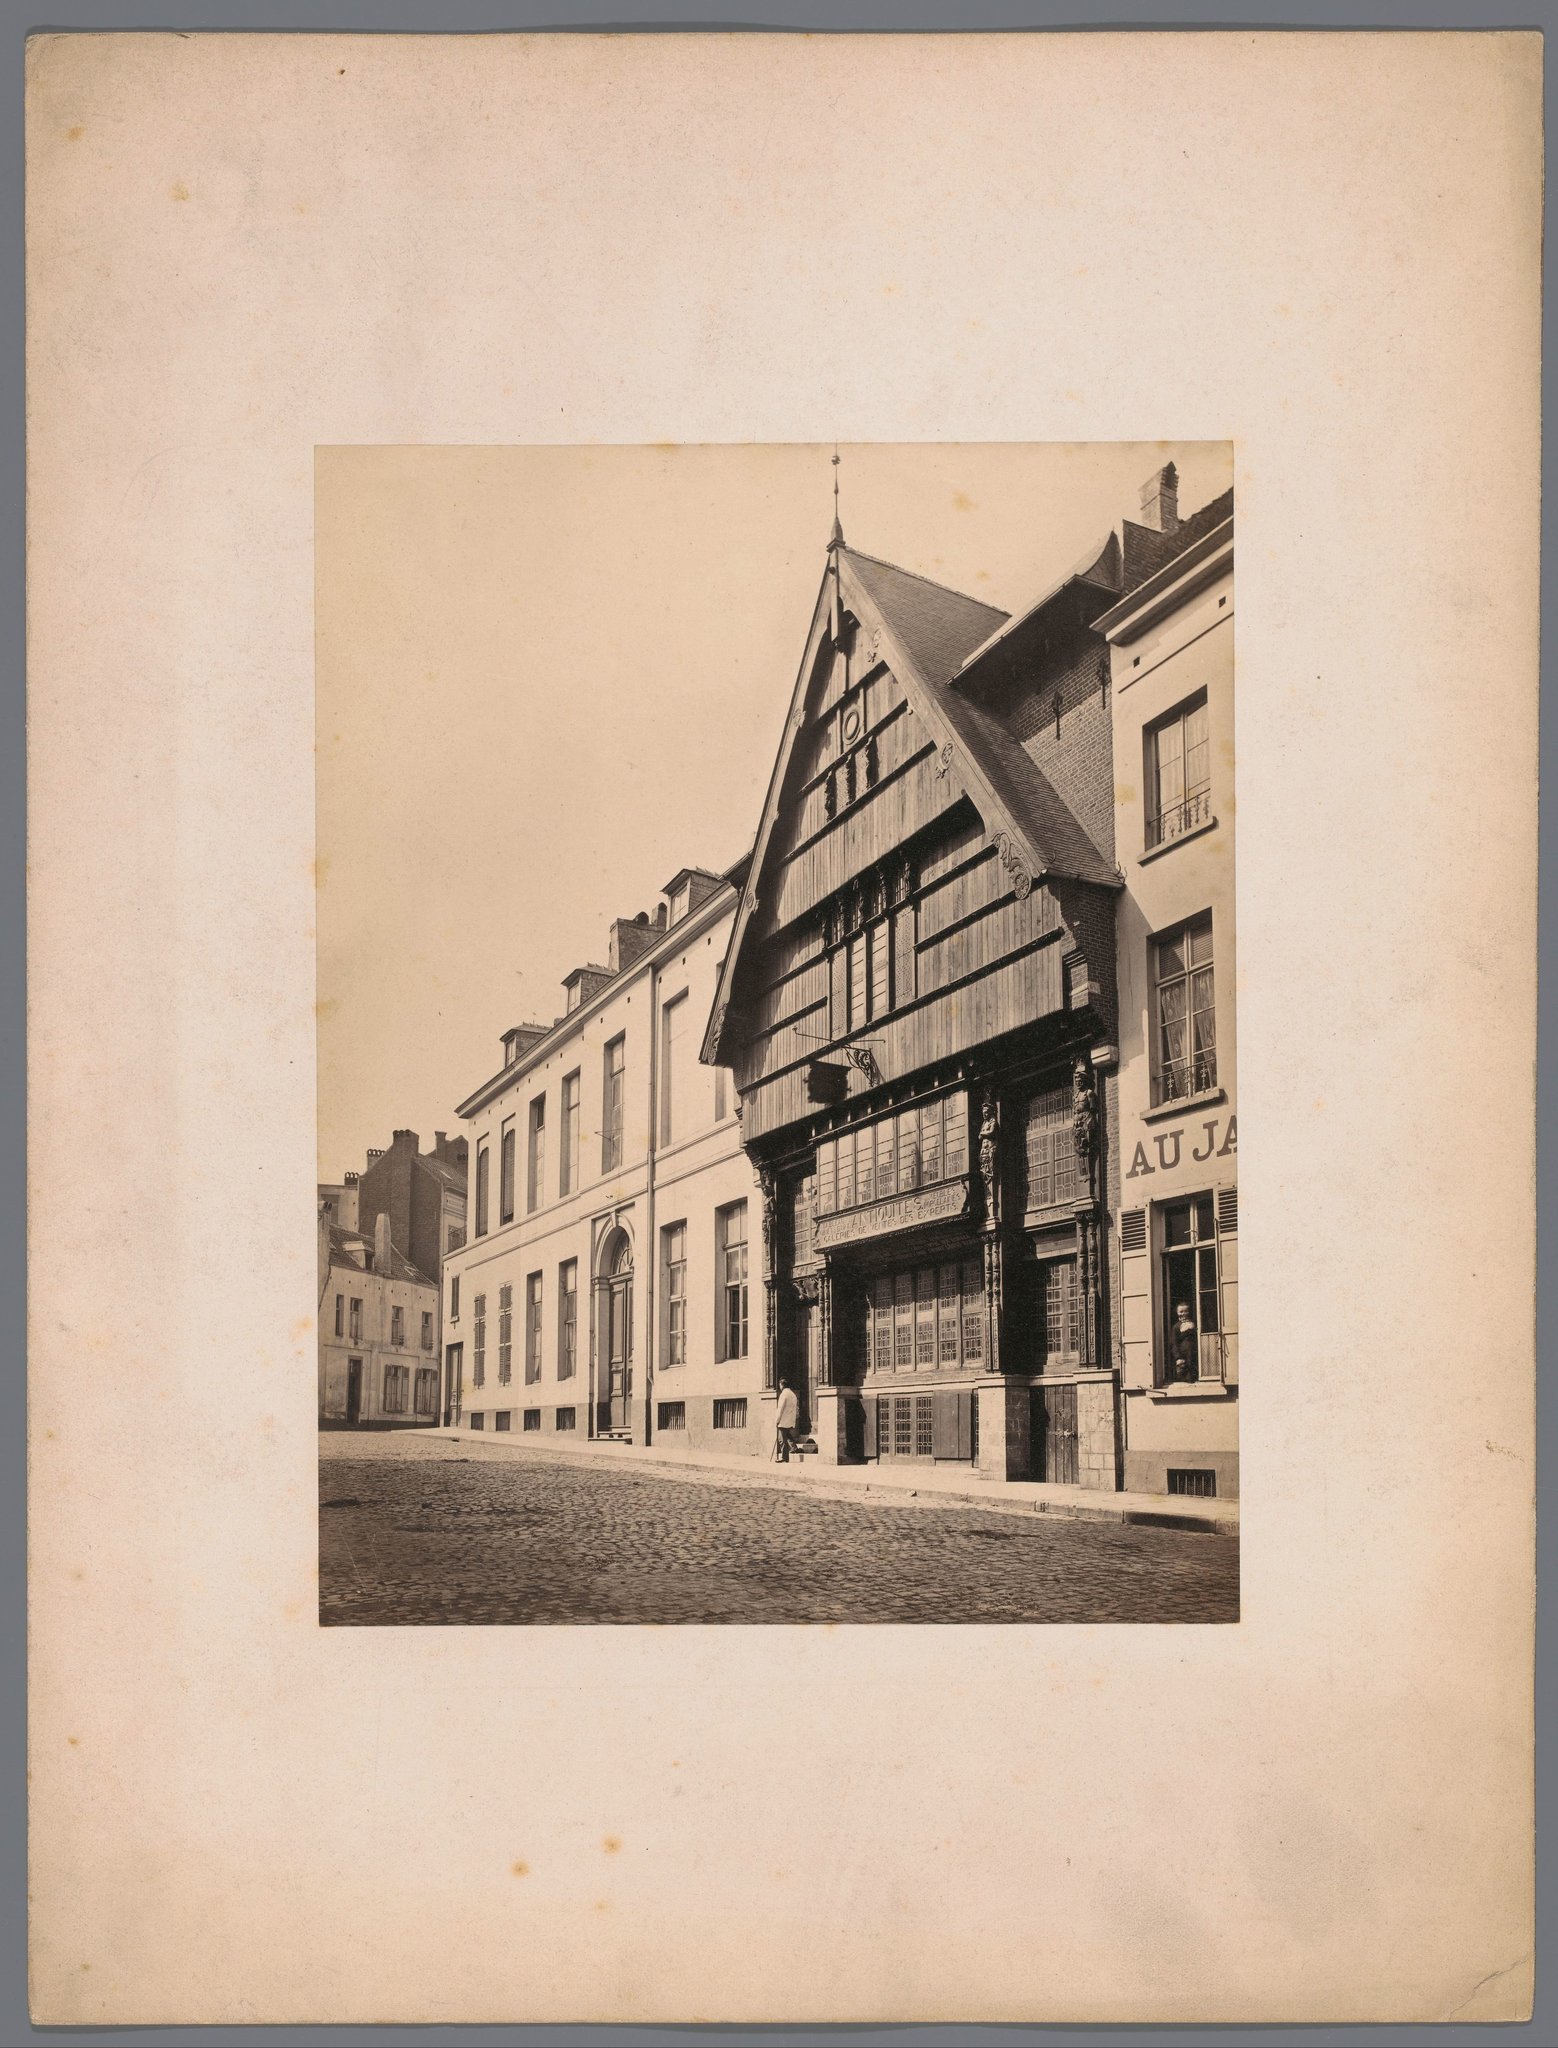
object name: photograph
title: Houten gevel van een antiekwinkel met atlanten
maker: Anonymous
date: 1850-1900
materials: cardboard, photographic support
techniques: albumen print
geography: france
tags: atlantes ~ architecture, façade (of house or building), france